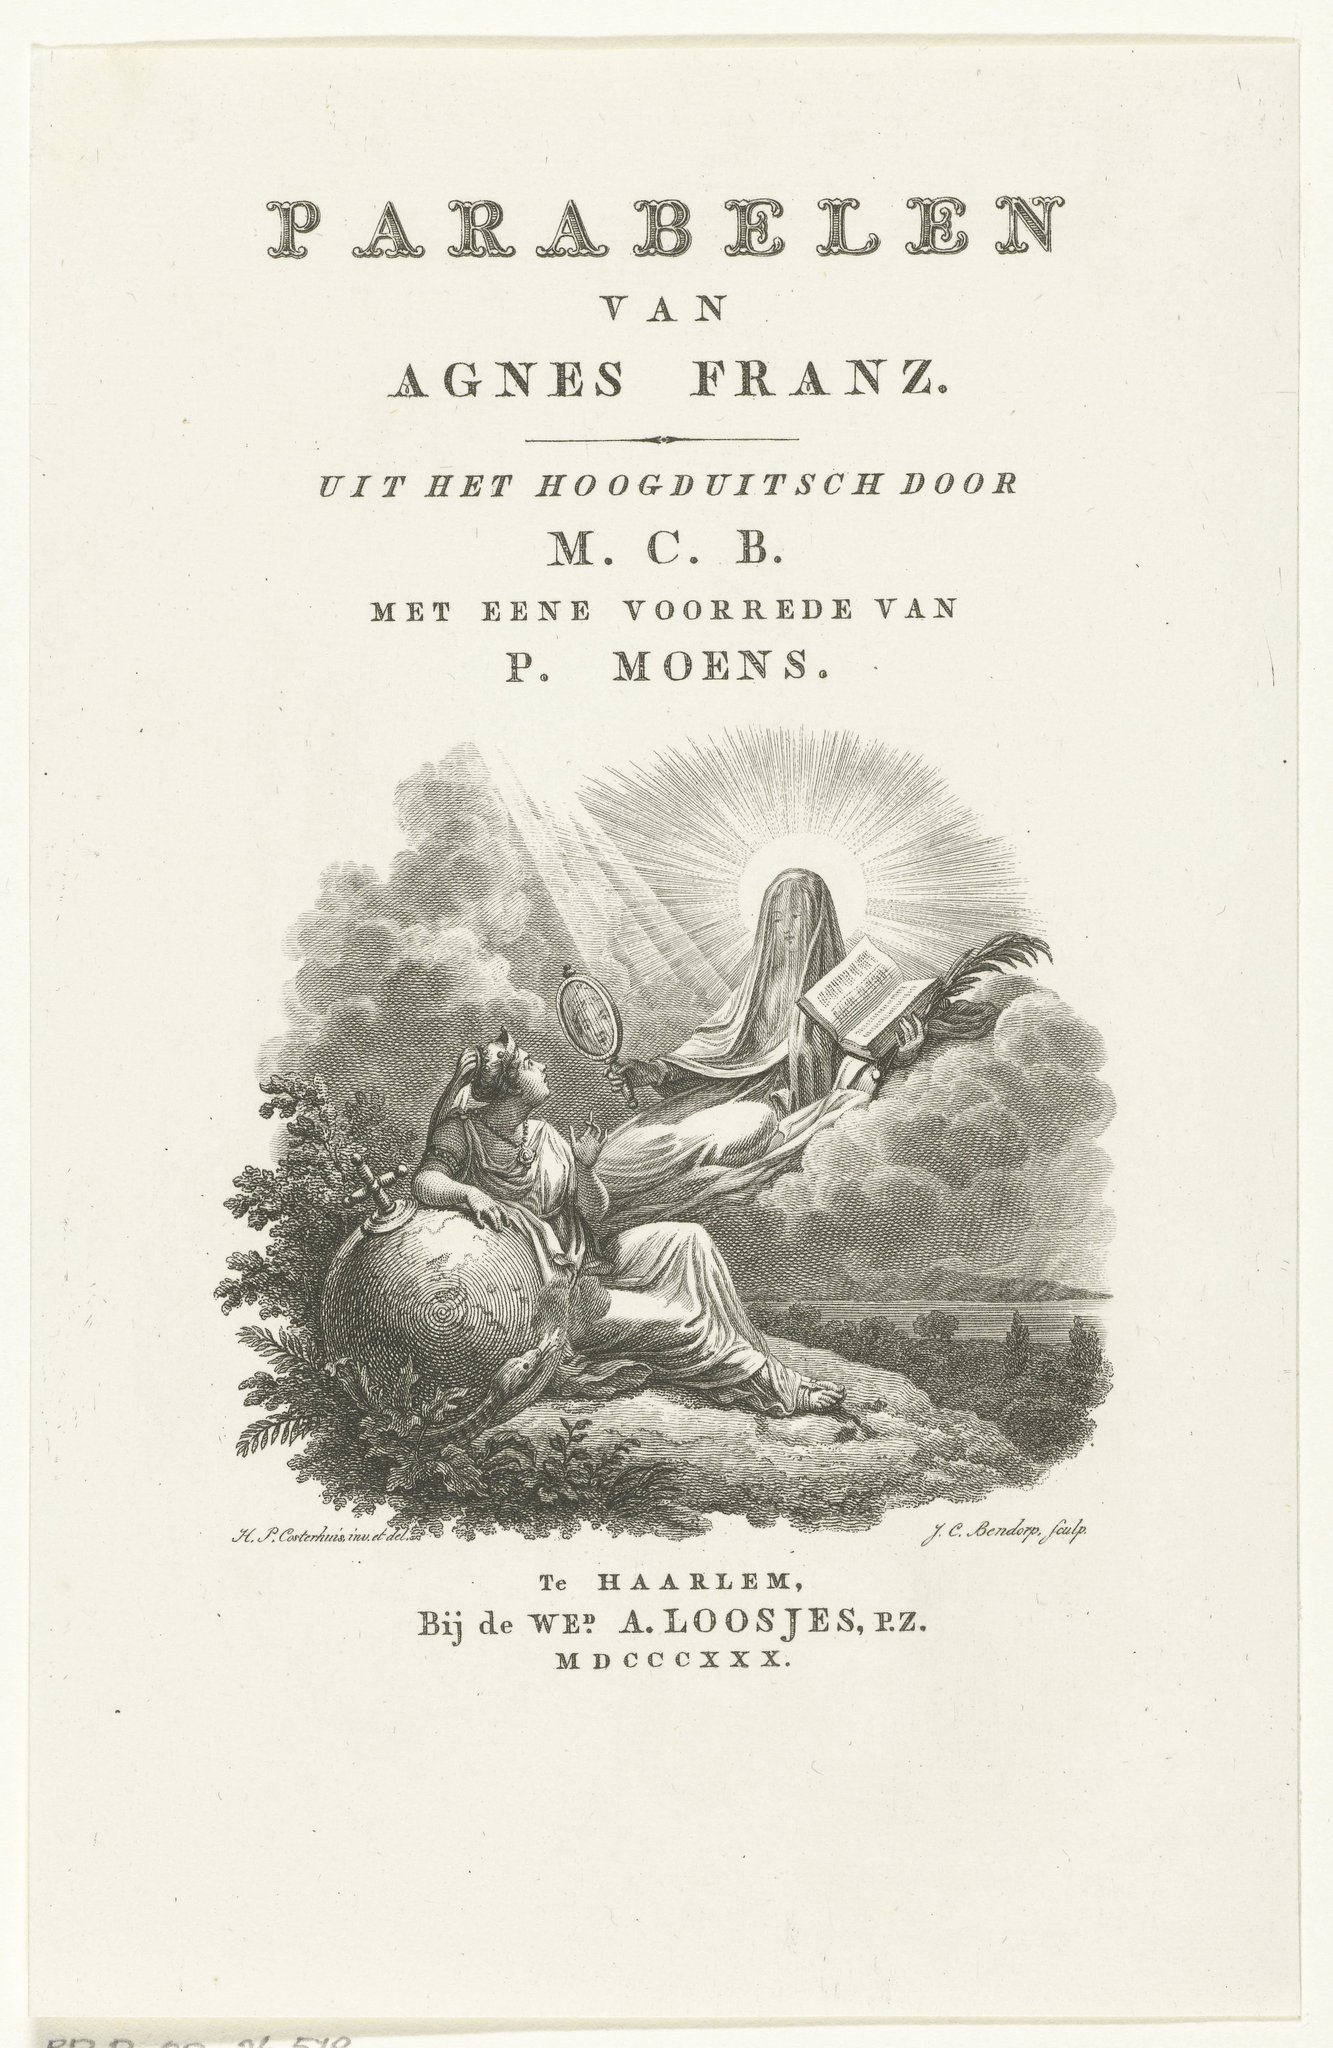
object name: print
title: Titelpagina voor: Belinfante, Parabelen van Agnes Franz, 1830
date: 1830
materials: paper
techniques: etching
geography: netherlands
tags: prudence, 'prudentia'; 'prudenza' (ripa) ~ one of the four cardinal virtues, mirror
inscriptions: collector's mark: Lugt 2228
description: Titelpagina voor: Belinfante (M.C.B.), Parabelen van Agnes Franz, uit het hoogduitsch door M.C.B. met eene voorrede van P. Moens, weduwe Adriaan Loosjes Pz. (uitgever), Haarlem 1830